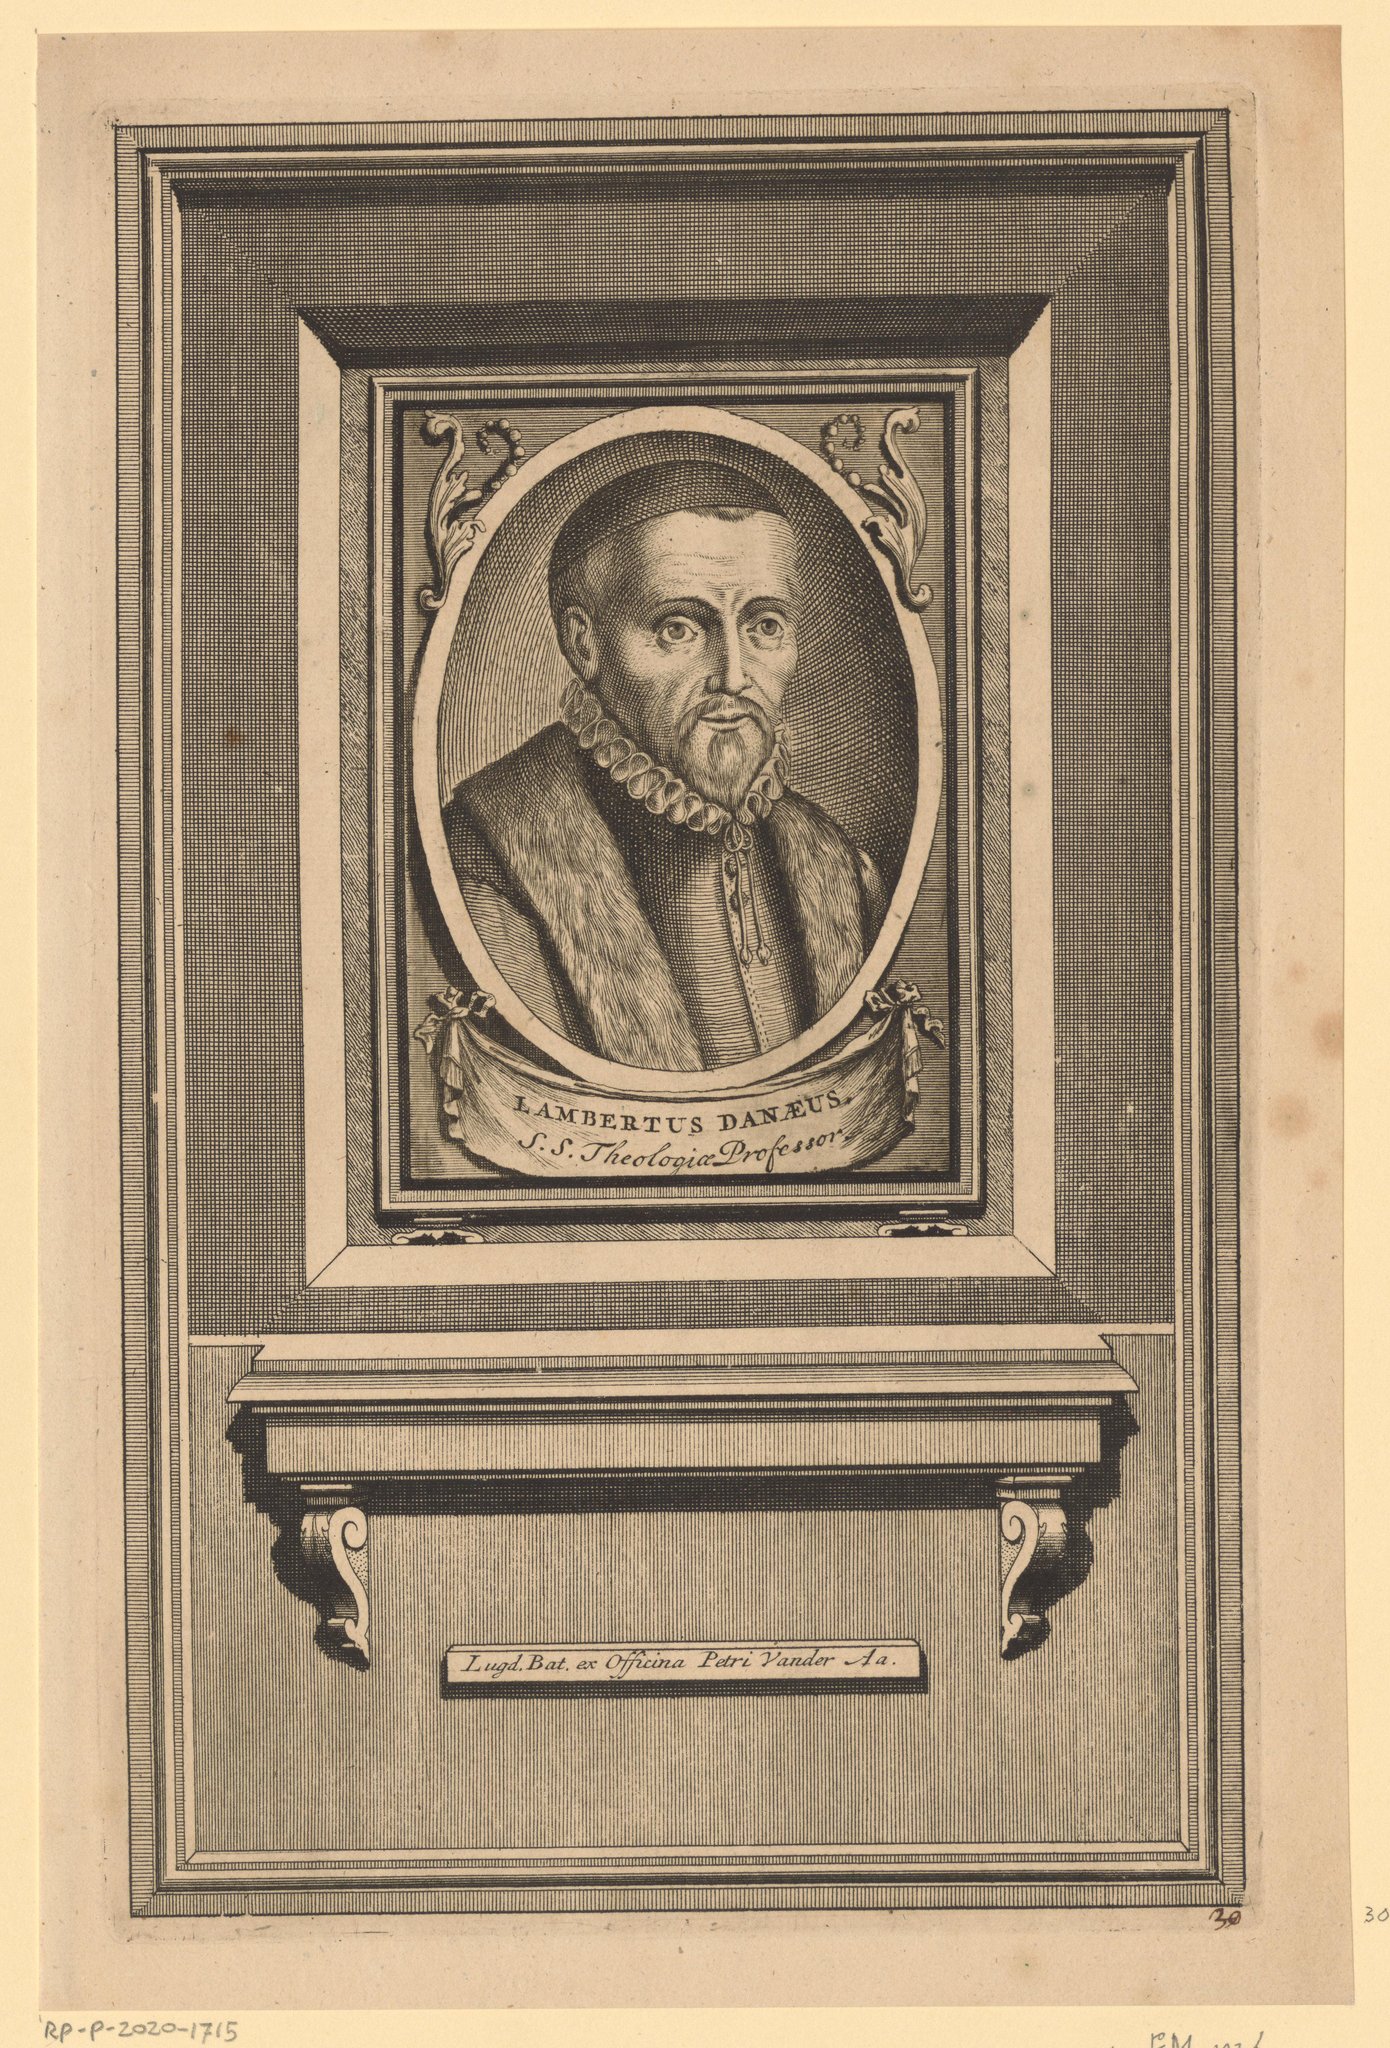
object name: print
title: Portret van Lambert Daneau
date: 1716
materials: paper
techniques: engraving, etching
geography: leiden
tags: theologian, historical persons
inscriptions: inscription: ‘30’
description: Prent mogelijk uit: Fundatoris curatorum et professorum celeberrimorum, (...) academia Lugduno-Batava (...). Leiden: Pieter van der Aa, [ca. 1716]. Prent ook gebruikt in eerdere en latere publicaties.